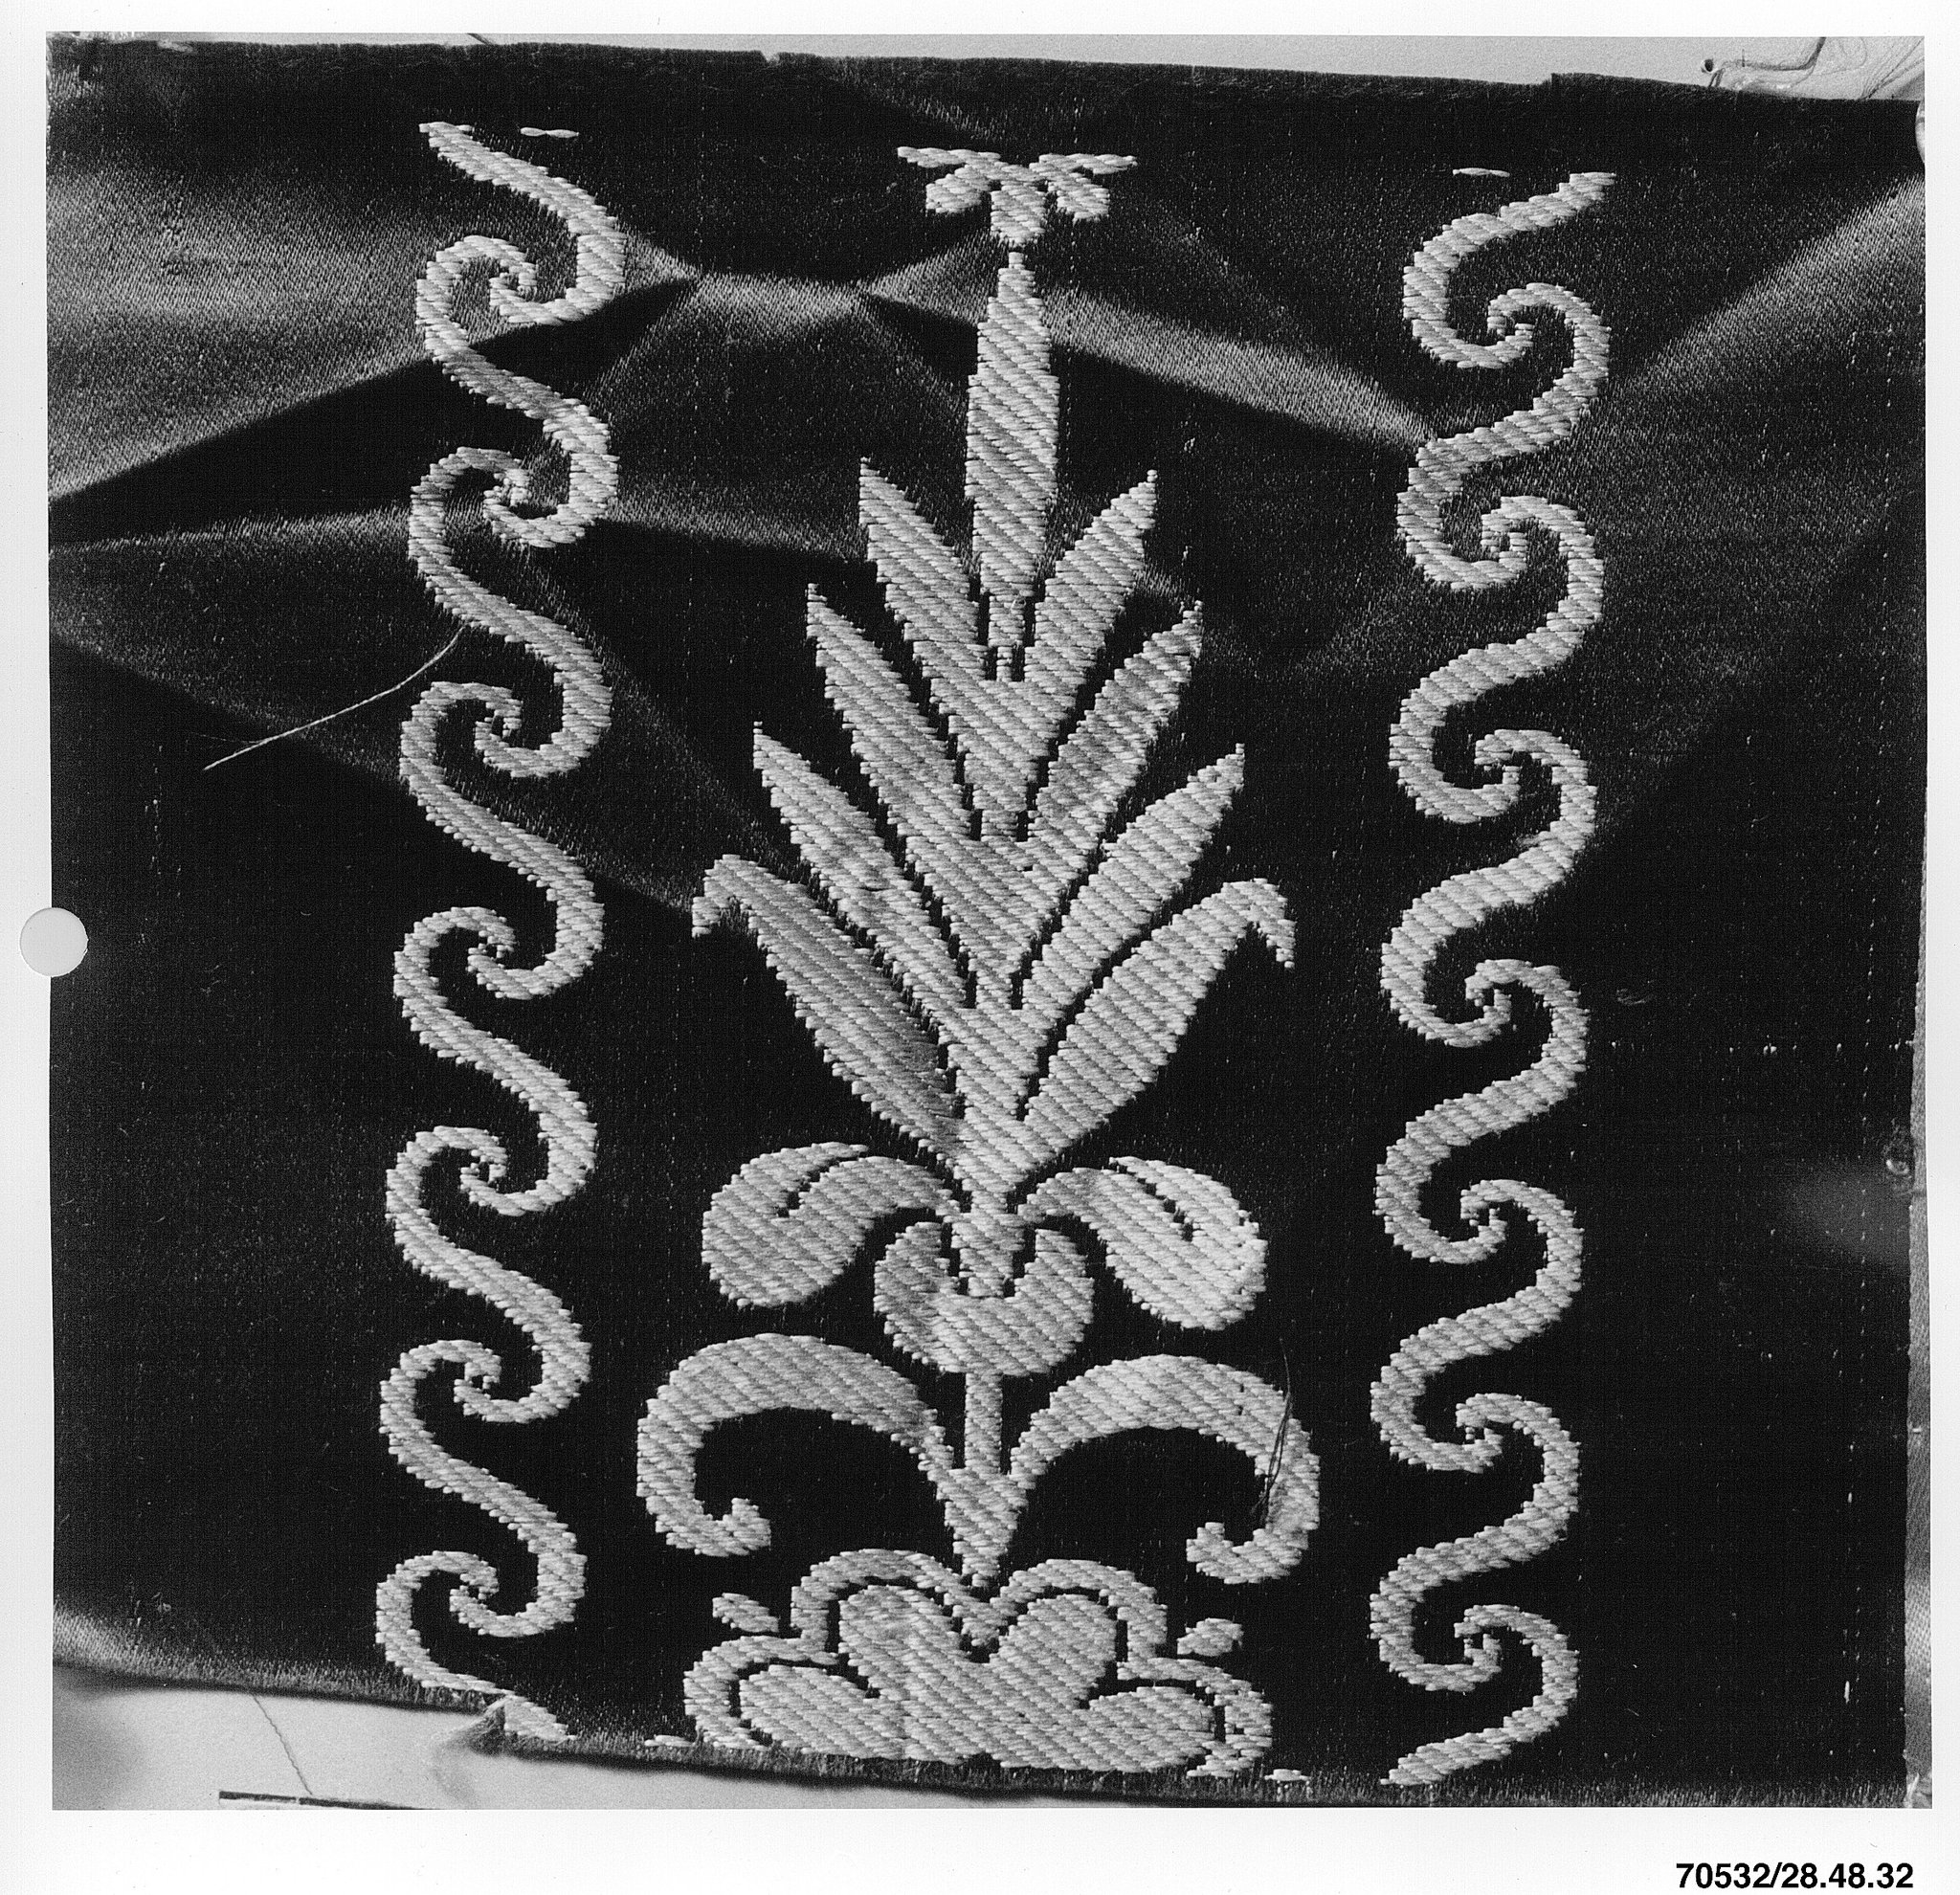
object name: piece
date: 1801-1900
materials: silk